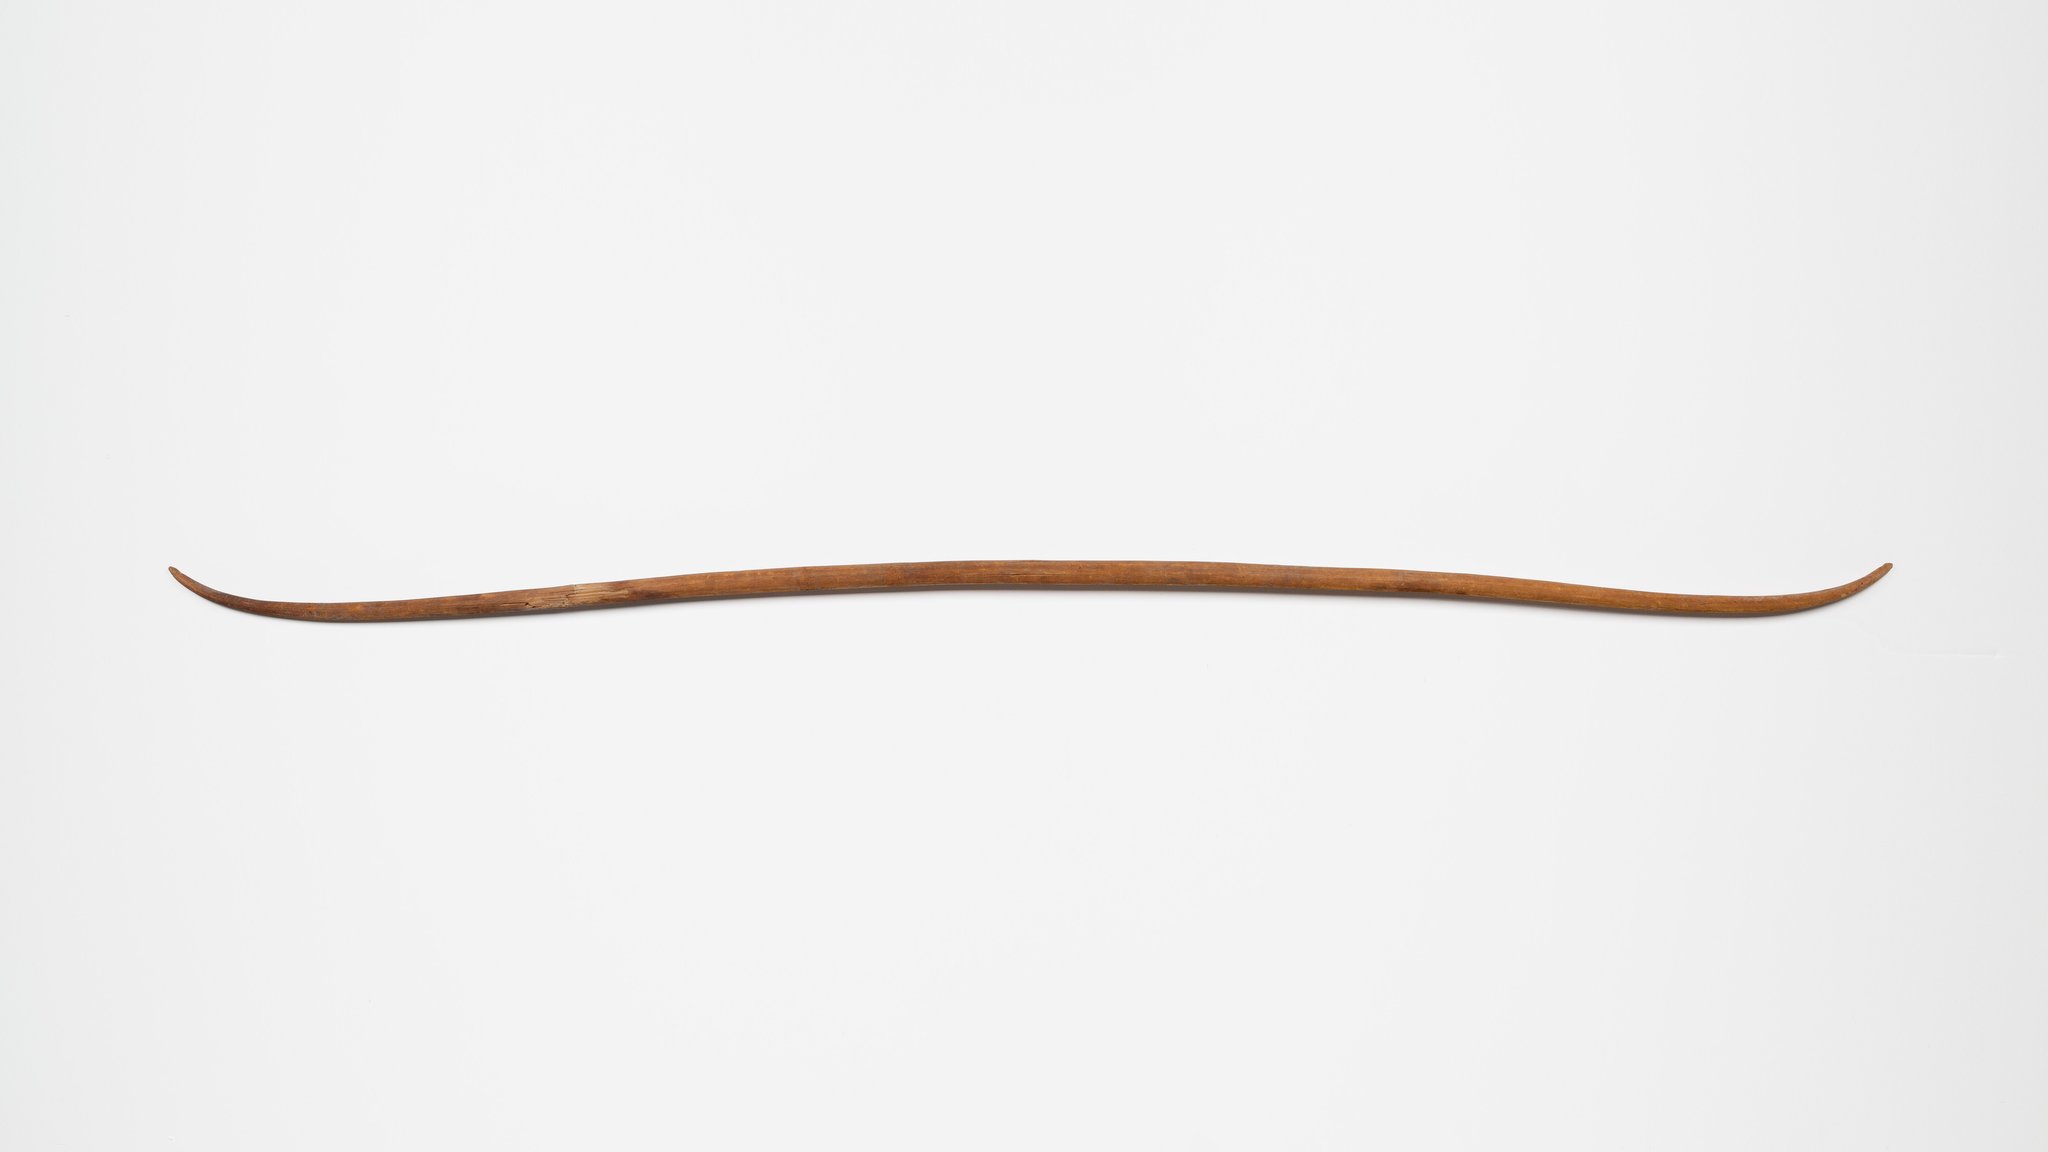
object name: bow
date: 1550-1295 BCE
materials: wood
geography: egypt